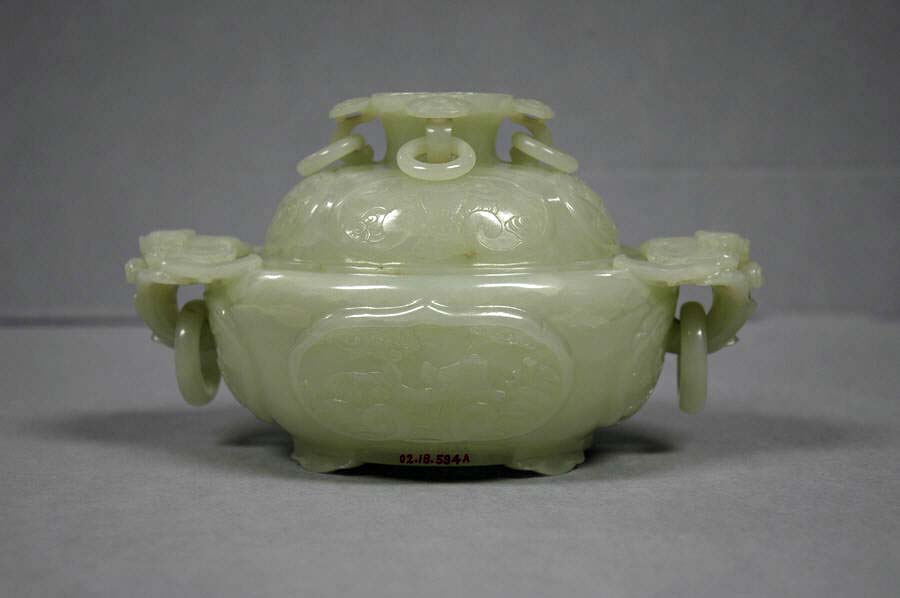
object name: covered bowl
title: Covered bowl with ring handles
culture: chinese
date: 1701-1900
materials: jade